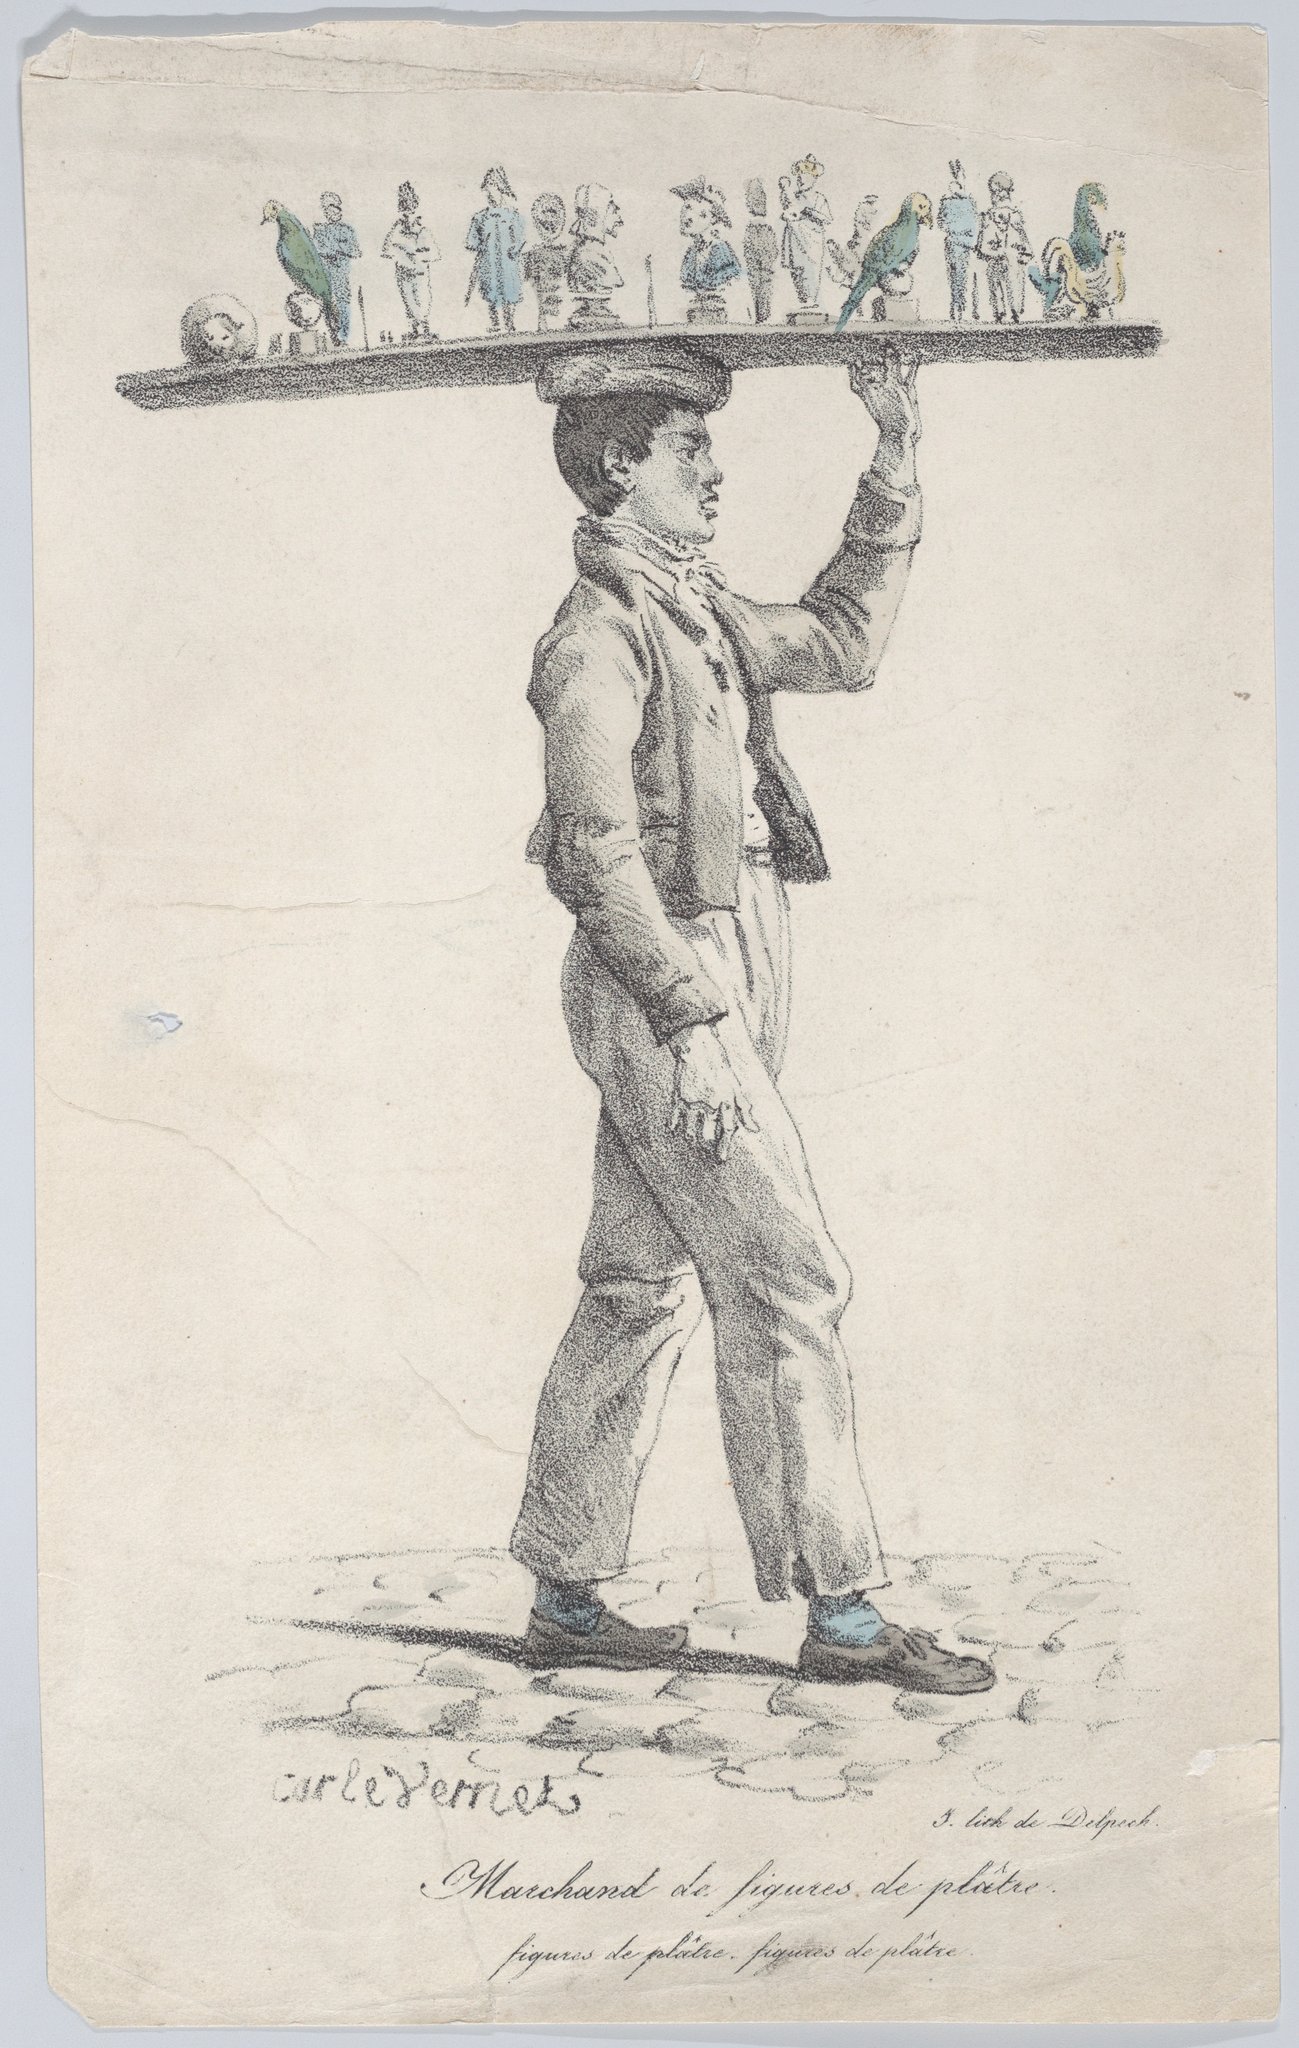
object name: print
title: Merchant of Plaster Figures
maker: carle vernet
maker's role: artist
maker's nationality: french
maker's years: 1758-1836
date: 1822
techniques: lithograph